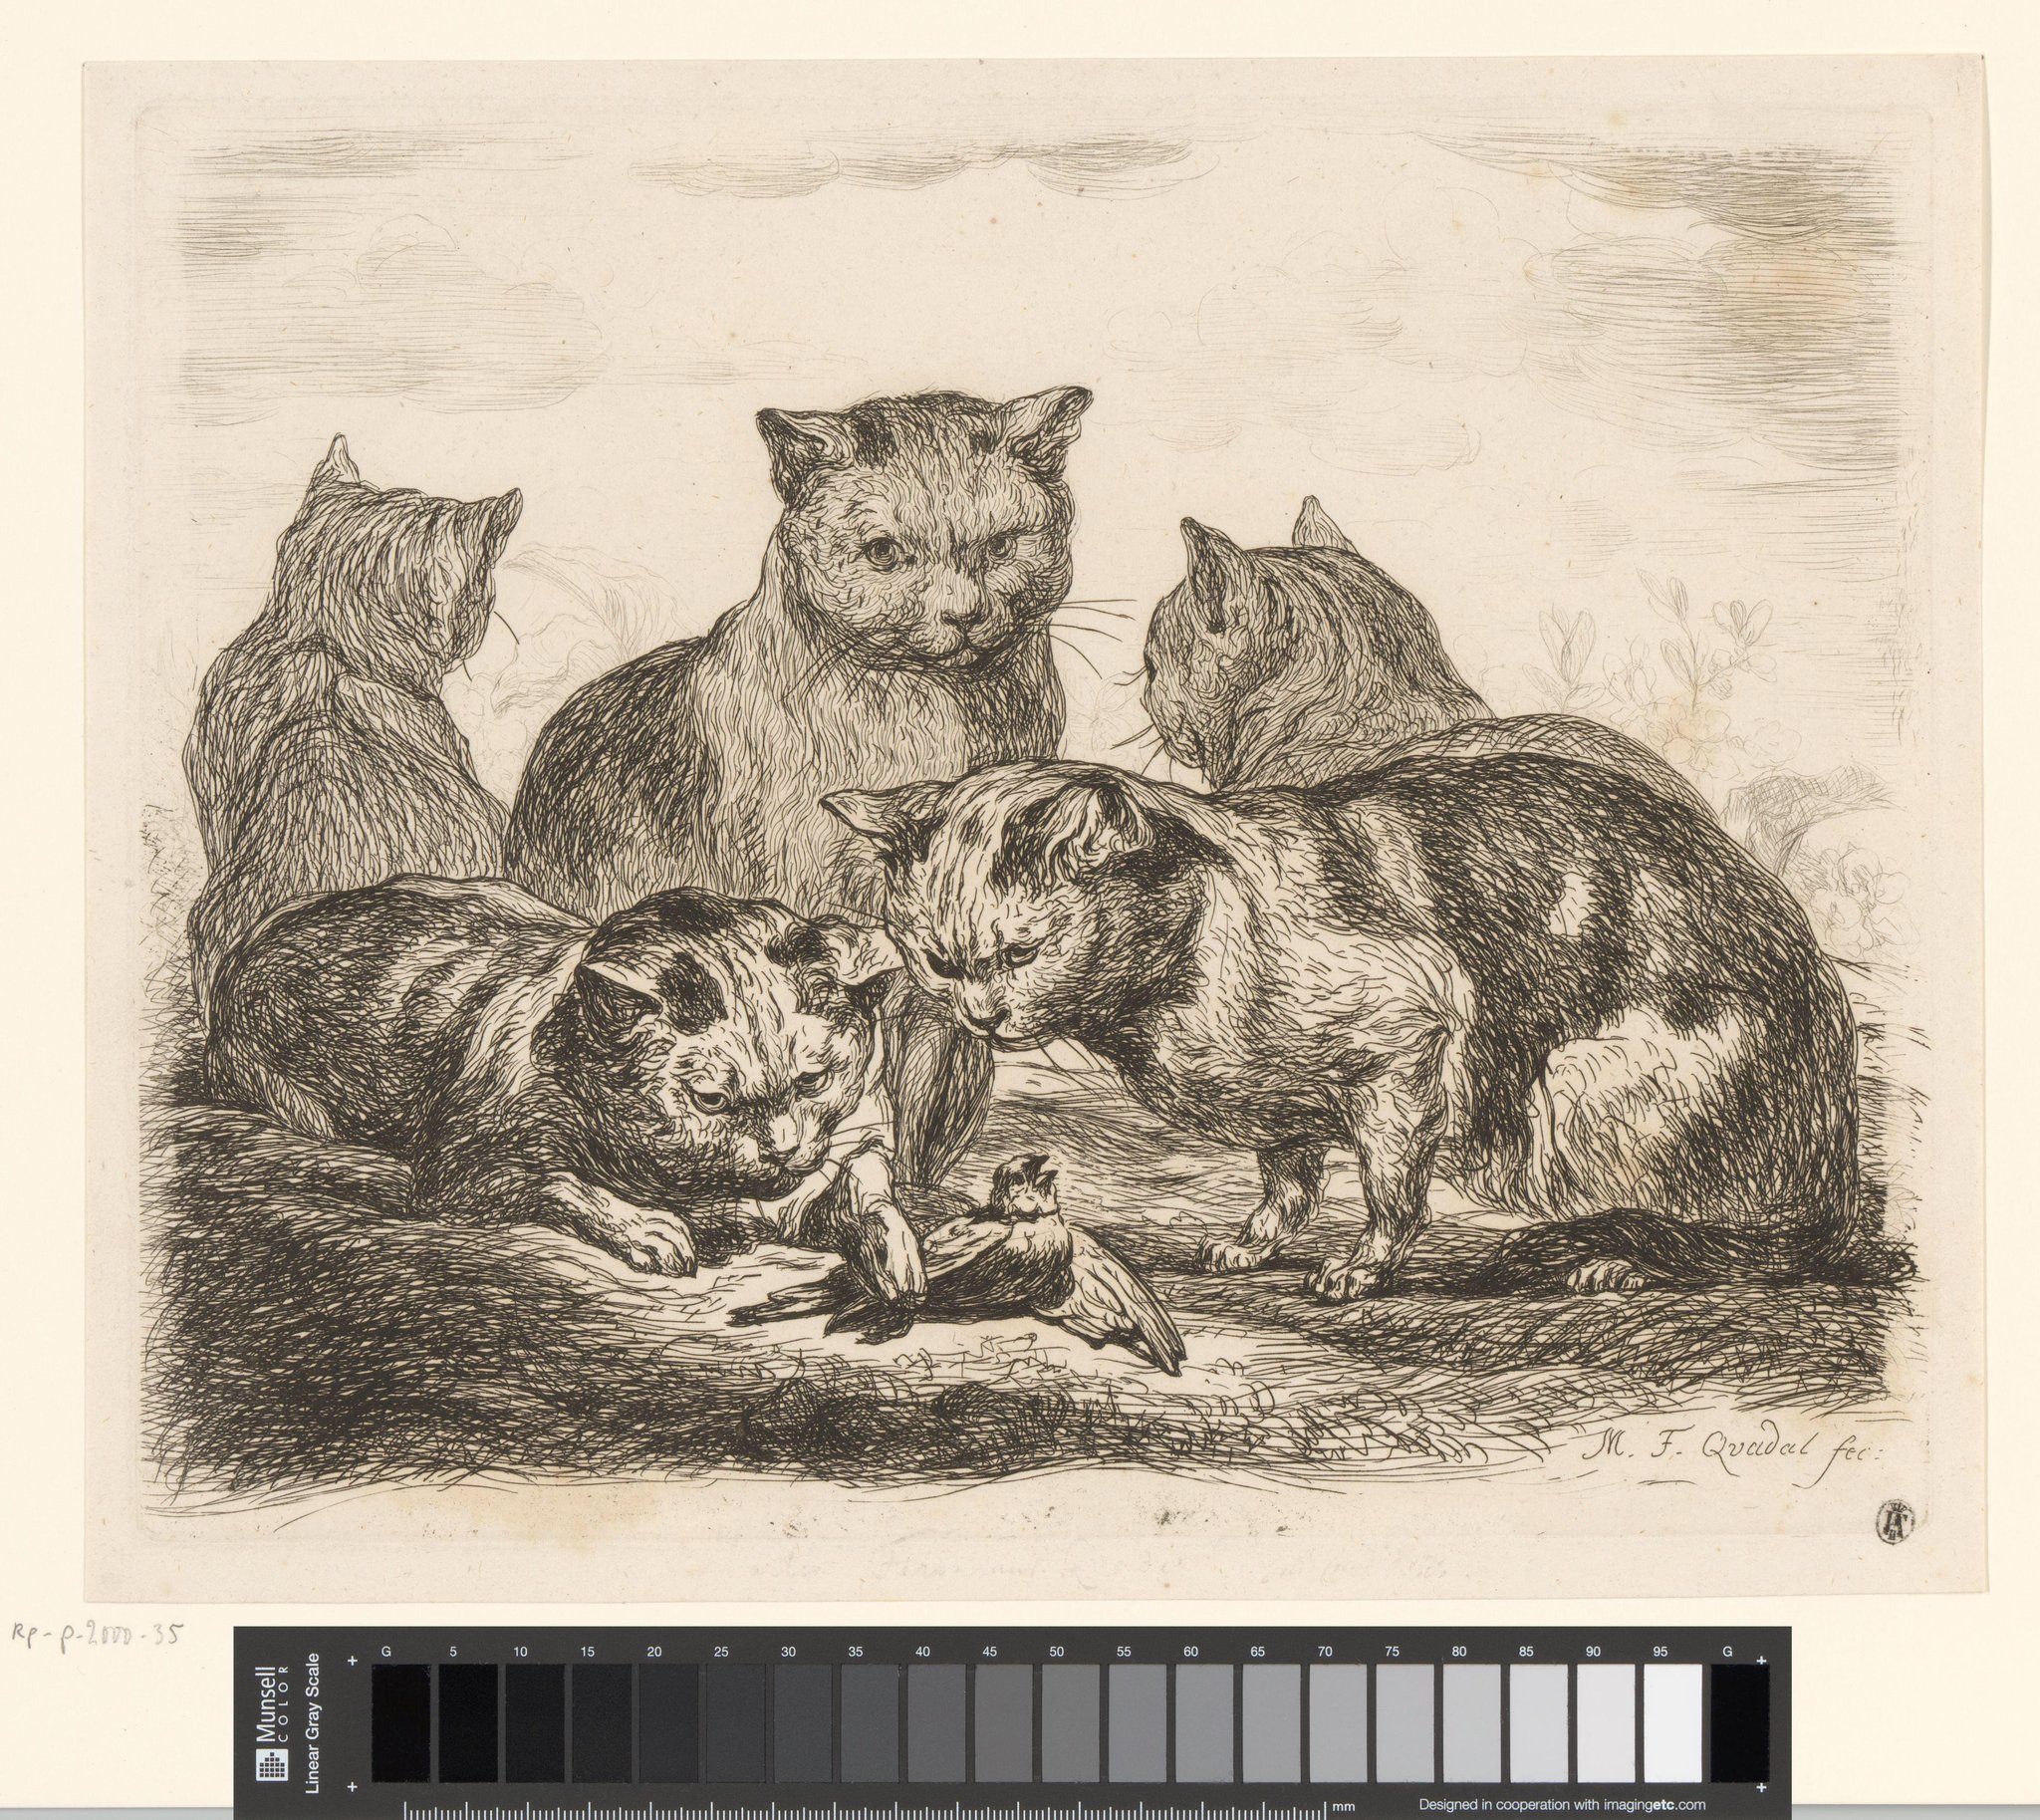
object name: print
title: A Variety of tame and wild animals, studies from nature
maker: martin ferdinand quadal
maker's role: print maker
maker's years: 1736-1808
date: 1793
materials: paper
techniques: etching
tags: cat, birds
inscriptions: collector's mark: Lugt 2760, collector's mark: Lugt 2228, collector's mark: Lugt 971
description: Prent afkomstig uit: A variety of Tame and Wild Animals Studies from nature (...). Londen: Quadal, 1793.